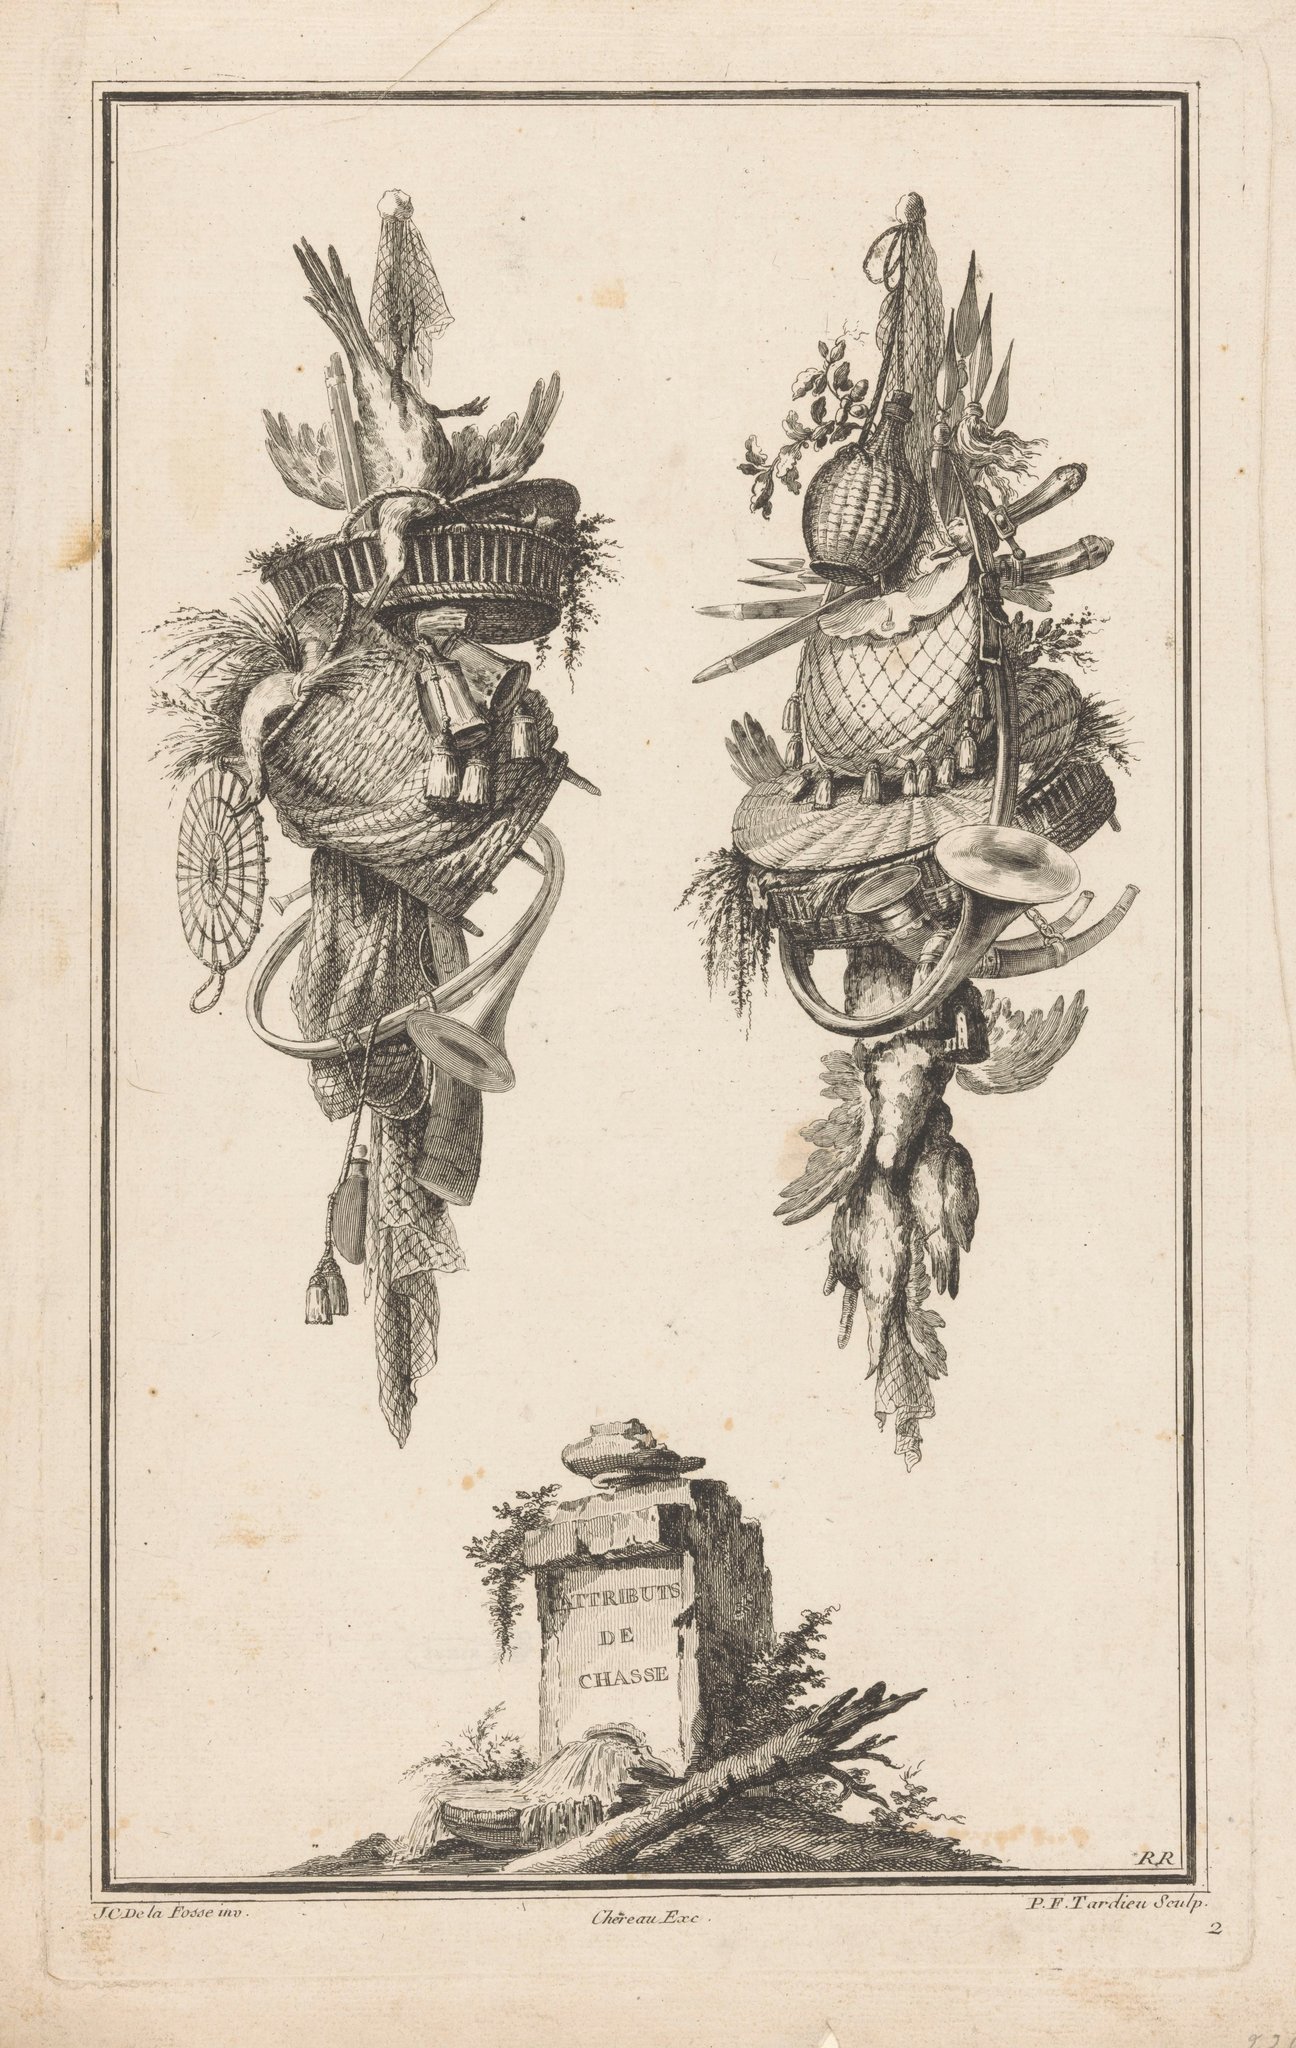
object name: print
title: IIe Volume De l'Oeuvre de J. Ch. Delafosse (...)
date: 1771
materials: paper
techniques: engraving, etching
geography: paris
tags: trophy, i.e.: decorative arrangement of symbolic or typical objects ~ ornament, hunting, chase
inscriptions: collector's mark: Lugt 2760, collector's mark: Lugt 2228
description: Links een trofee met twee manden, geschoten vogels en een jachthoorn. Rechts een trofee met een drinkfles, een tas, een mand, een jachthoorn en geschoten vogels.